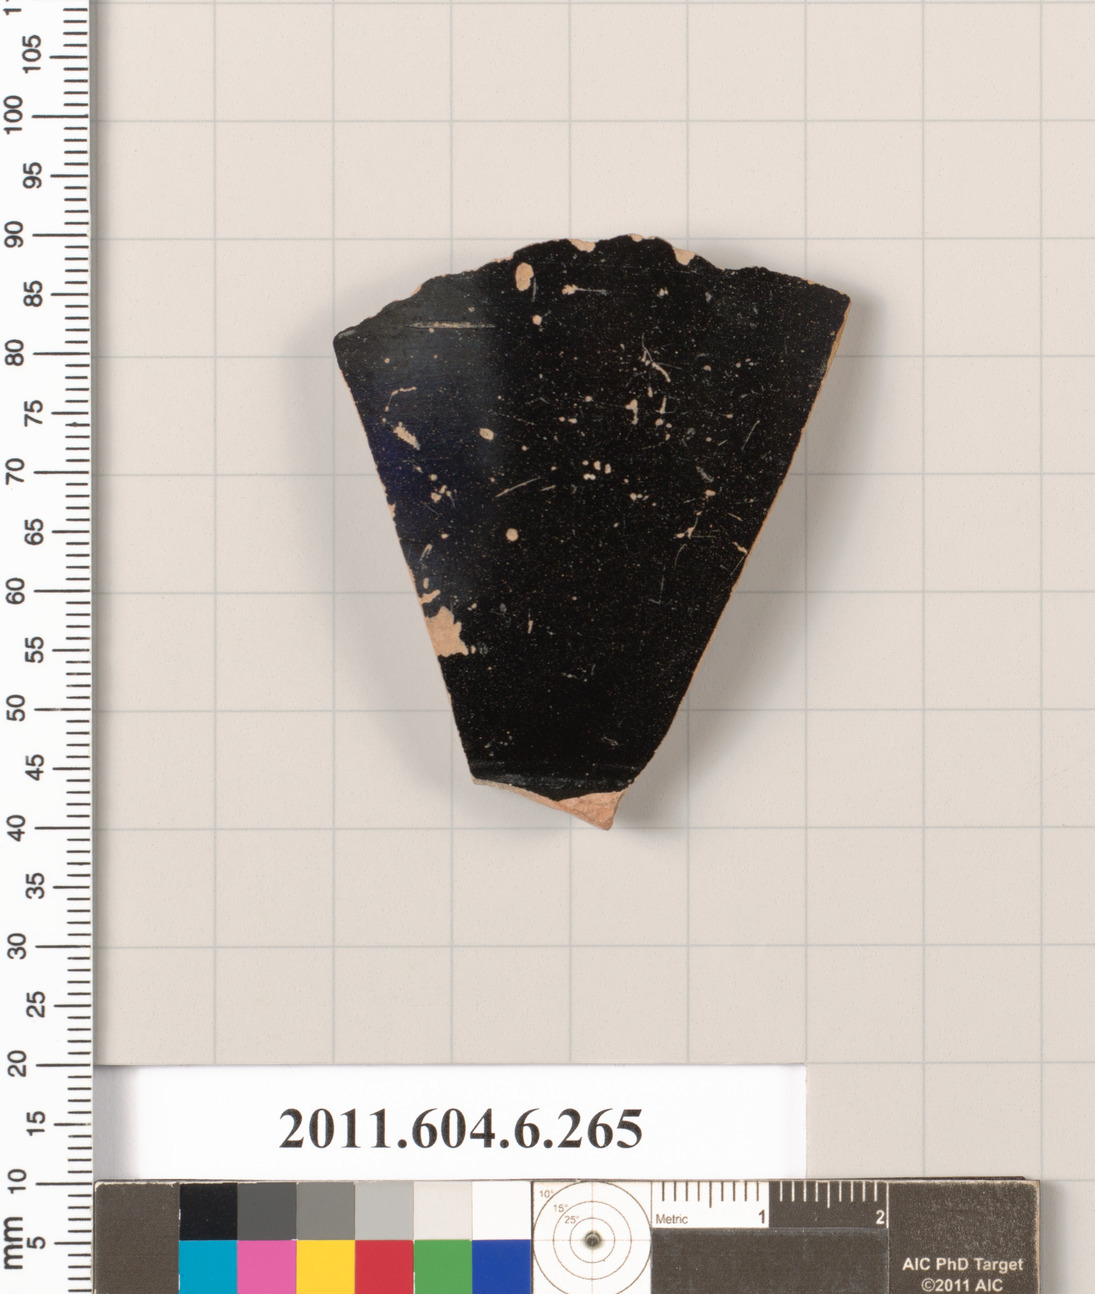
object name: undetermined open shape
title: Terracotta fragment of an open shape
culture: greek, attic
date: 500-401 BCE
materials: terracotta